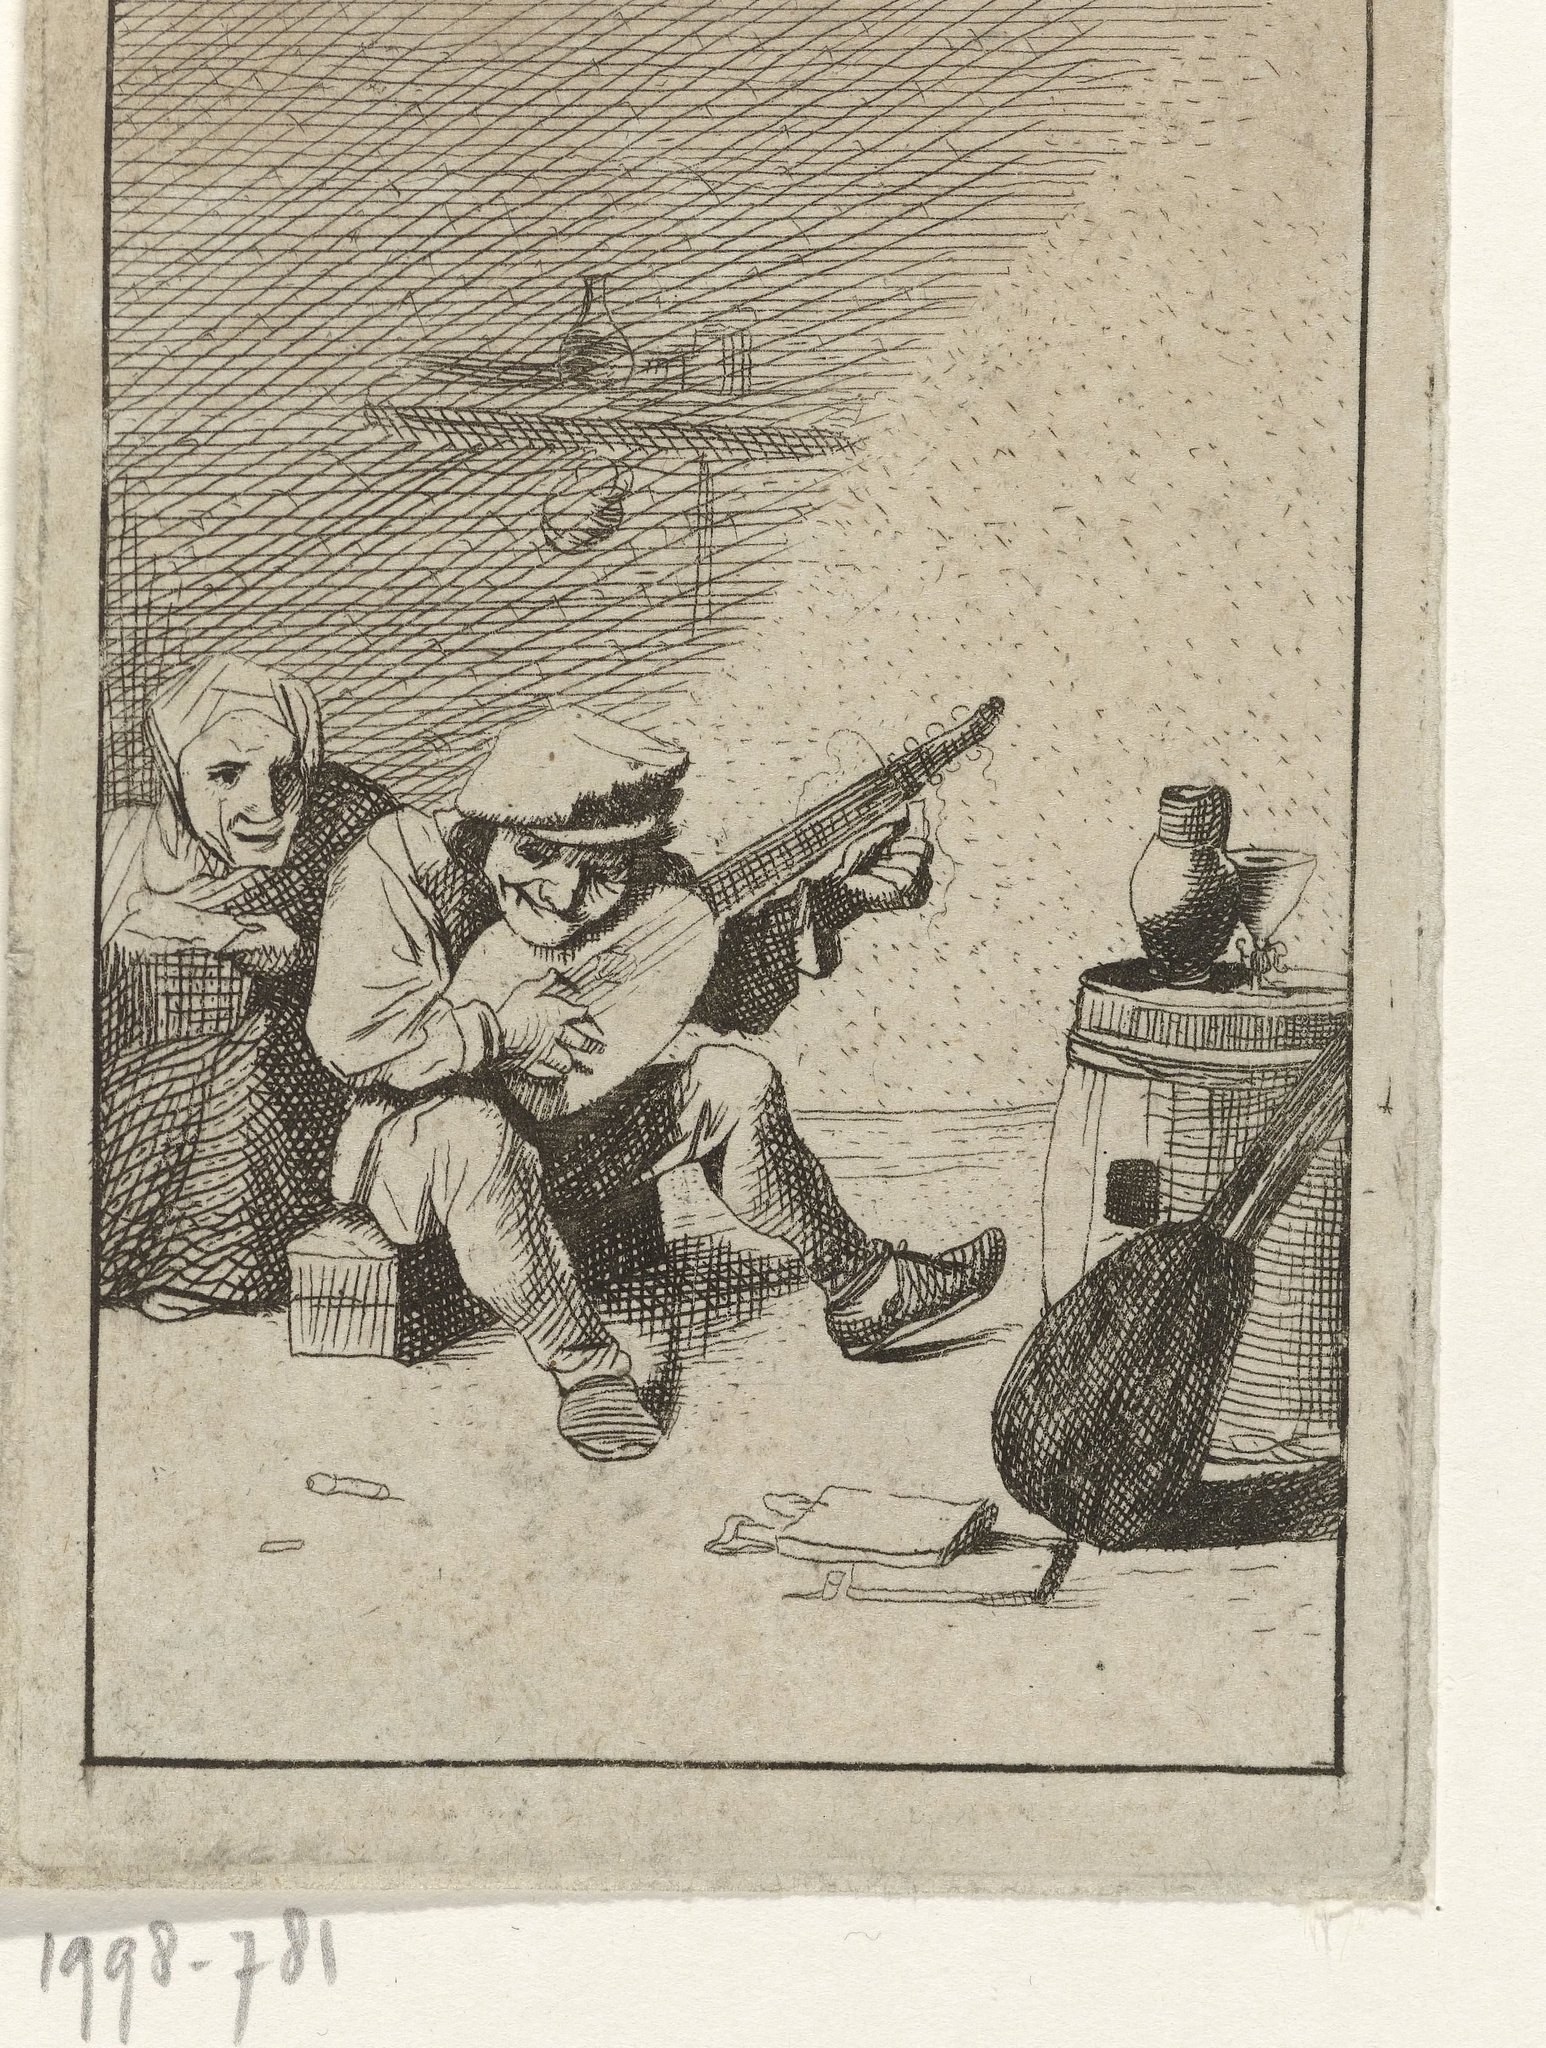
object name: print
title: Luitspelende boer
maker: Anonymous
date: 1700-1799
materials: paper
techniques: etching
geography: netherlands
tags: lute, and special forms of lute, e.g.: theorbo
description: Luitspelende boer in een kaal vertrek met rechts een ton waarop een kruik; een luit staat ertegenaan. Achter de boer een luisterende oude vrouw. (naar David Teniers ?)